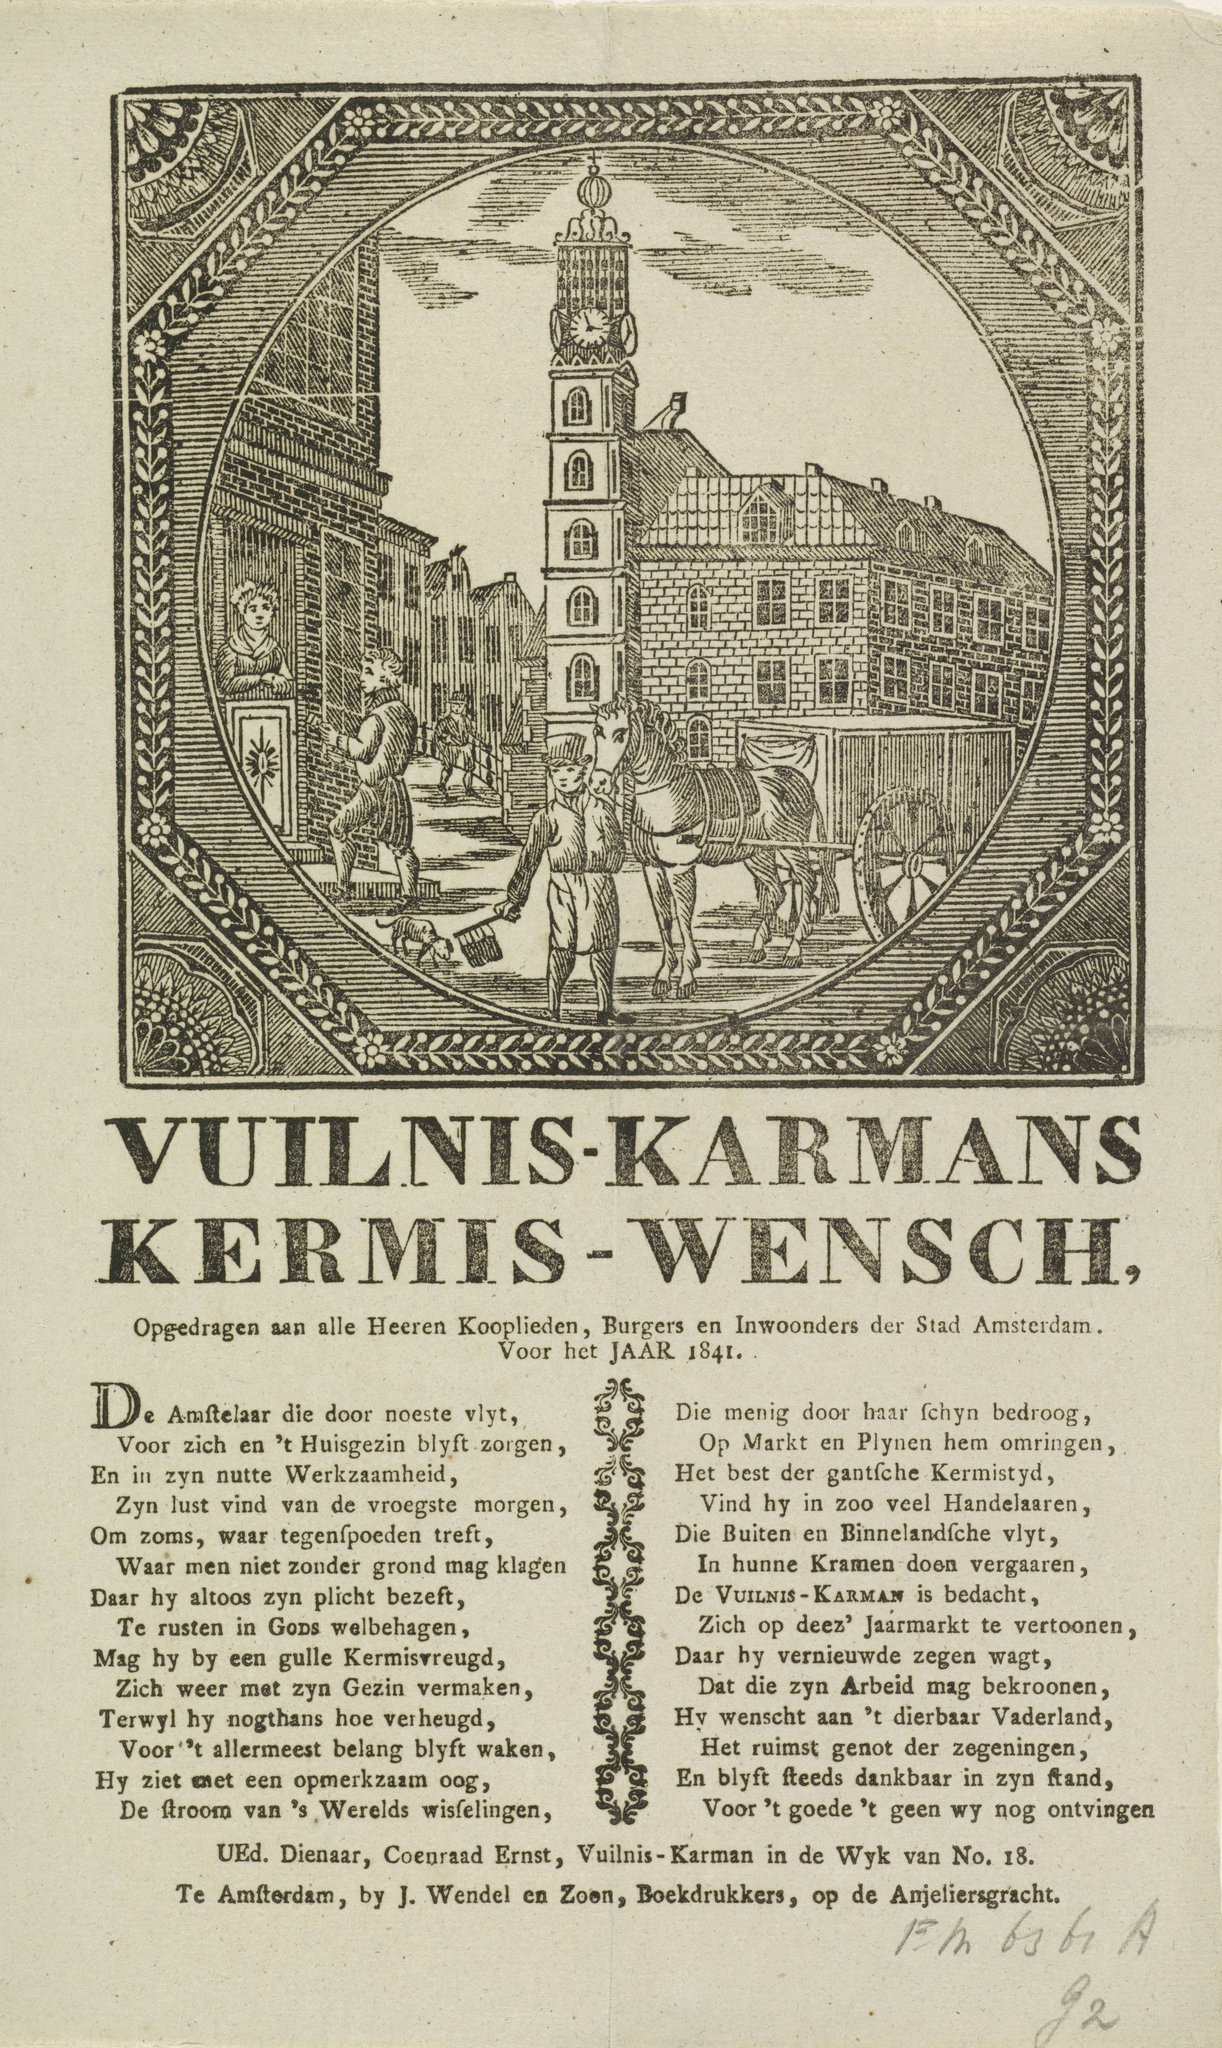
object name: print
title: Kermisprent van de vuilnismannen van Amsterdam voor het jaar 1841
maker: Anonymous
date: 1841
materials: paper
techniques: letterpress printing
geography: amsterdam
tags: street, garbage collection, amsterdam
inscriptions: collector's mark: Lugt 2228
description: Kermisprent van de Amsterdamse vuilnismannen voor het jaar 1841. Ronde voorstelling binnen achtkantige rand met een gezicht bij de Munt te Amsterdam waar een man met een ratel bij een vuilniskar staat. Een andere man haalt bij een huis geld op. Met gedicht in twee kolommen. Van de vuilniskarman in de wijk no. 18: Coenraad Ernst.